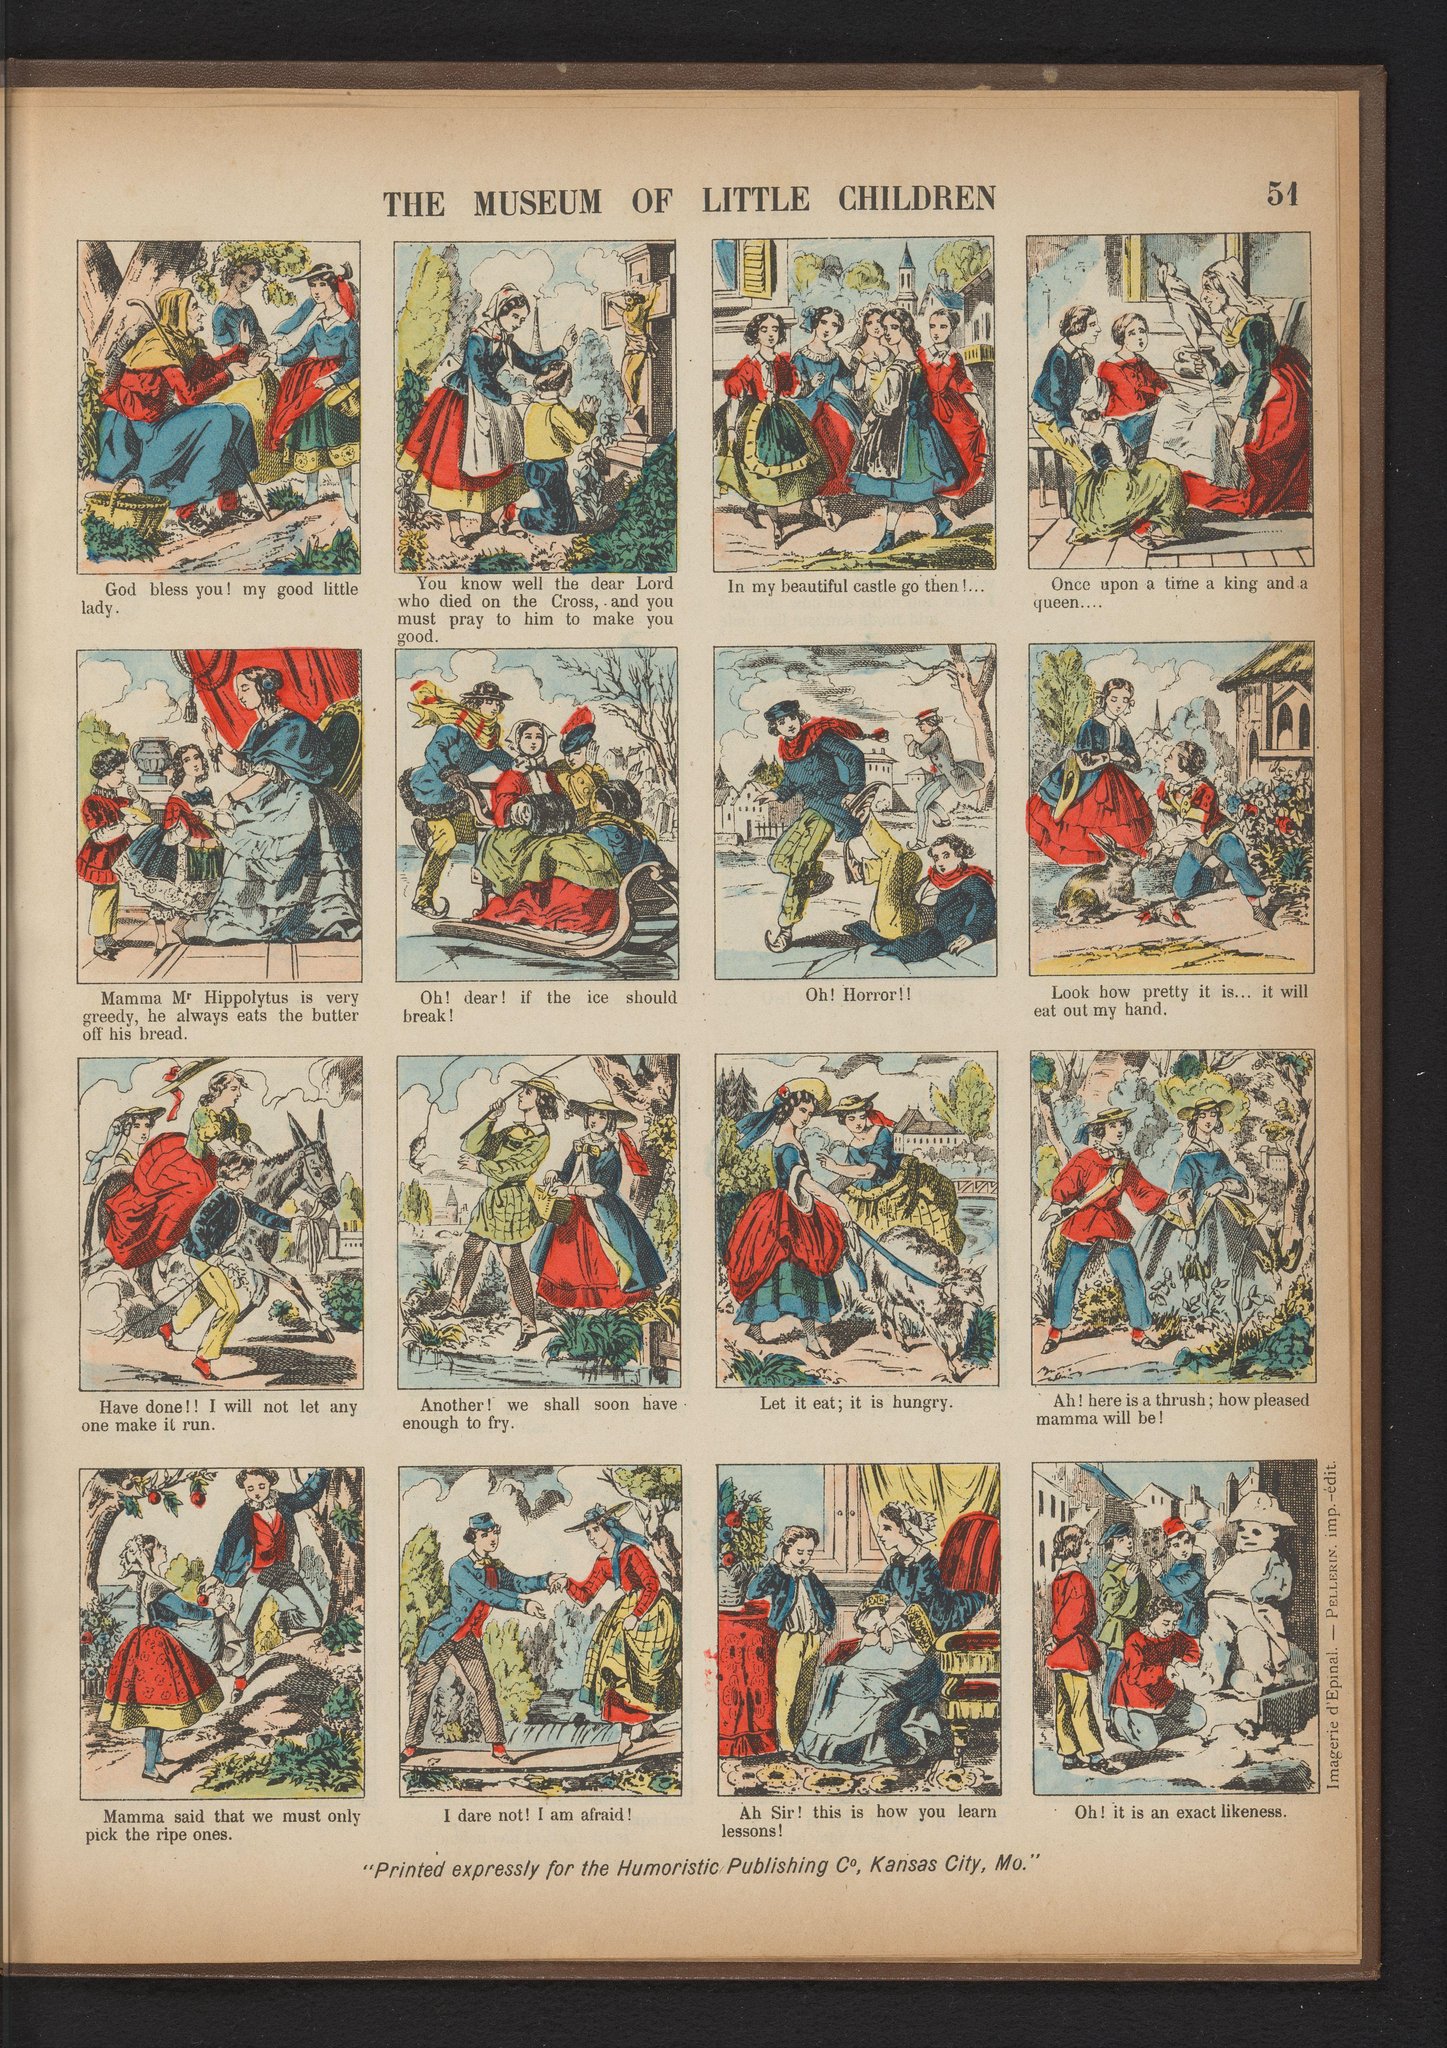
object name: print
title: The proud Matilda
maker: Anonymous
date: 1893-1894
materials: paper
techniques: colour, letterpress printing, lithograph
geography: kansas city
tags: arrogance; 'arroganza' (ripa), contempt, girl (child between toddler and youth)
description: Blad met zestien voorstellingen met het verhaal van hooghartige Matilda die zich niet met het gewone volk in wil laten. Onder elke voorstelling een onderschrift in het Engels. Deze prent maakt deel uit van een album.